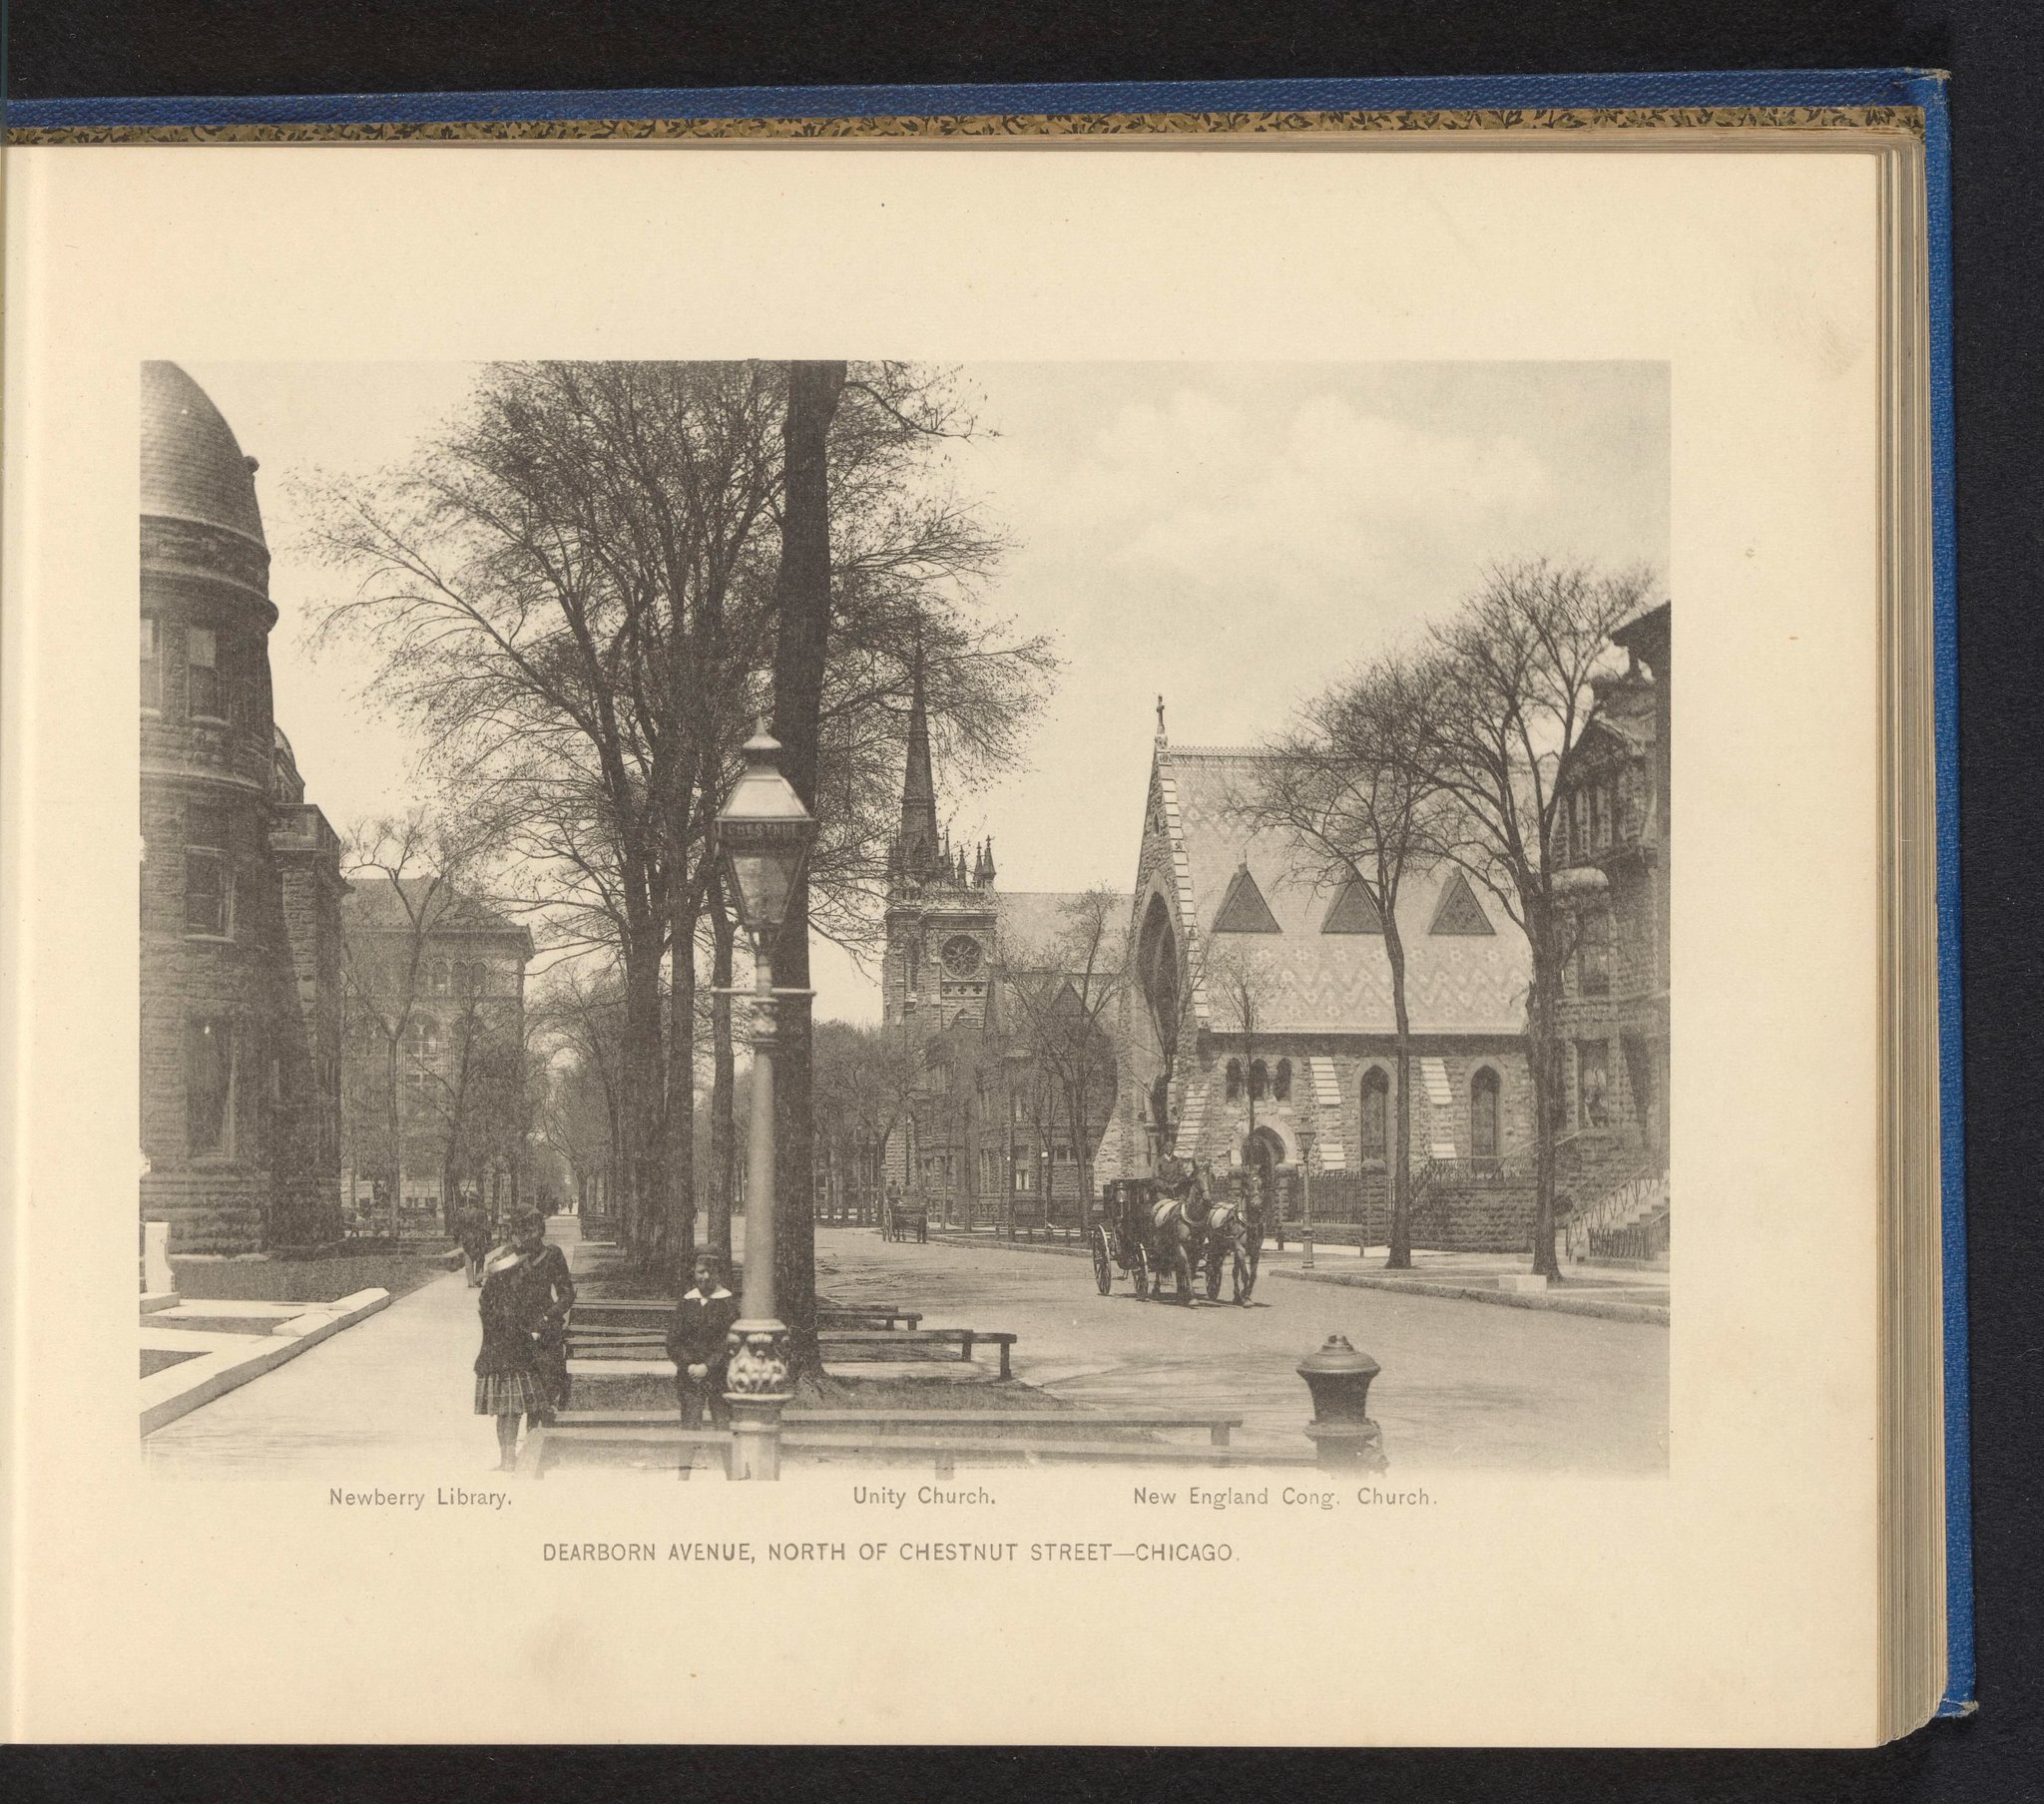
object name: photomechanical print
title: Dearborn Avenue, north of Chestnut Street - Chicago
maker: Anonymous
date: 1893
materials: paper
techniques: photograph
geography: chicago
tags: four-wheeled, animal-drawn vehicle, e.g.: cab, carriage, coach, church (exterior), street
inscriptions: inscription: ‘Newberry Library, Unity Church. New England Cong. Church.’